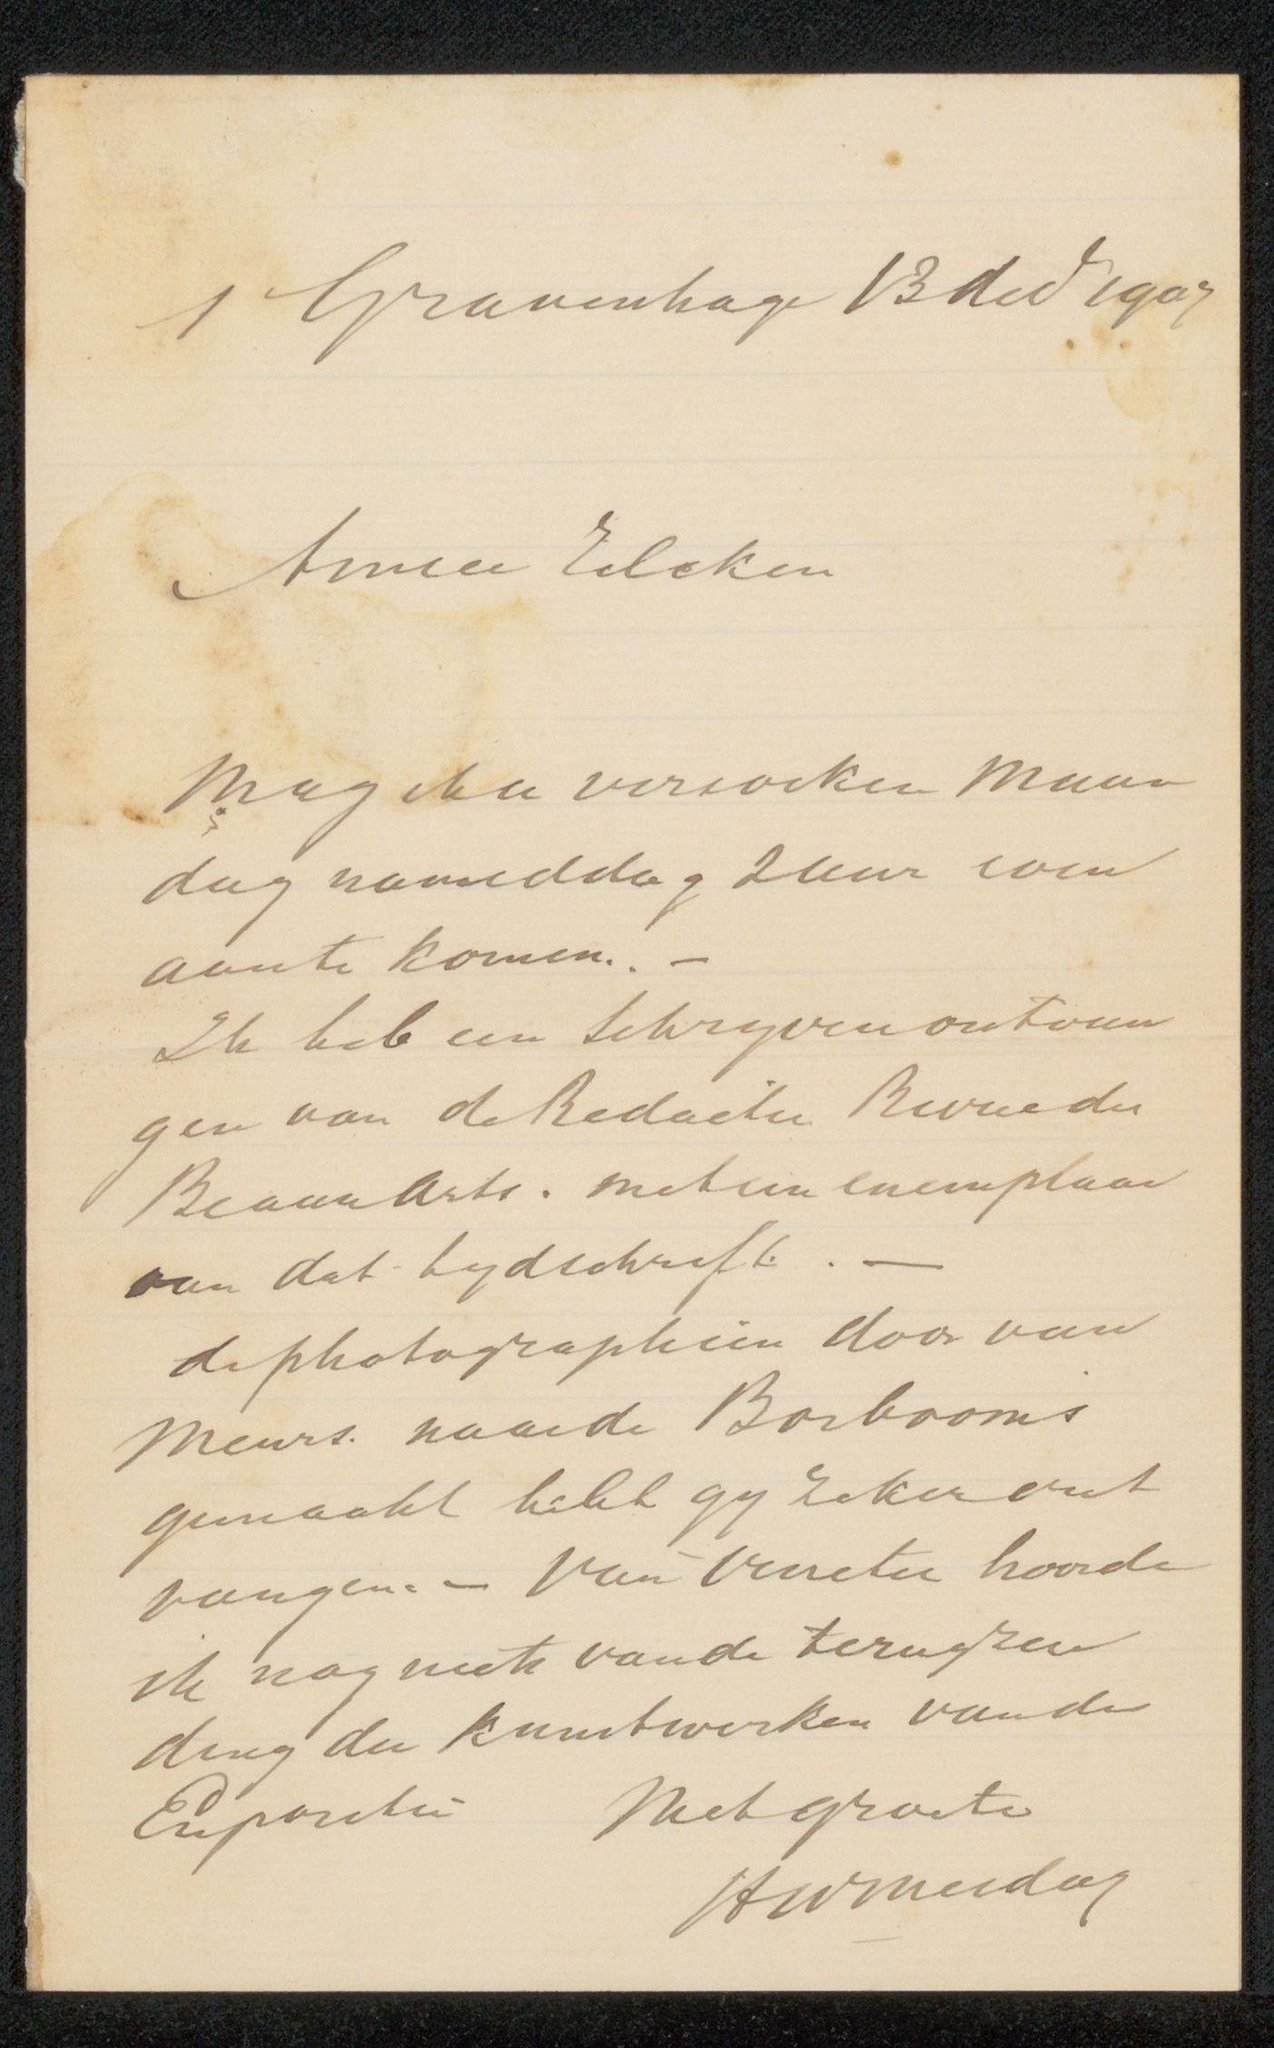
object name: letter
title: Brief aan Philip Zilcken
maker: hendrik willem mesdag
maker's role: draughtsman, painter, print maker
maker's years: 1831-1915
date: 1907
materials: ink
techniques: pen, writing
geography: the hague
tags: johannes bosboom, amsterdam, artist, willem jan gerrit van meurs, the hague, painter, philip zilcken, photography, cinematography, exhibition ~ art, venice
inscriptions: collector's mark: ‘RPK’